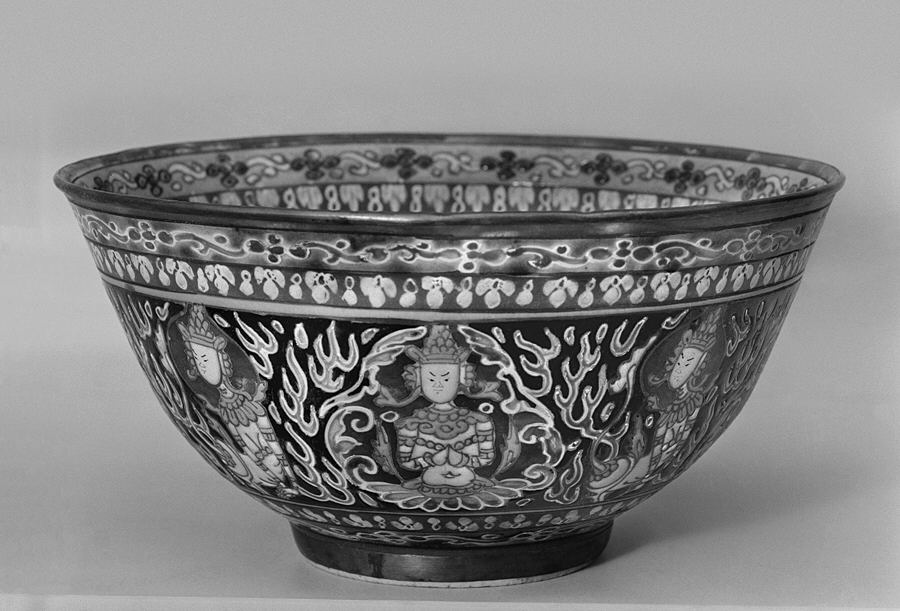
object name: bowl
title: Bowl with mythical Thai figures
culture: chinese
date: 1801-1900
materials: enamel, porcelain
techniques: overglaze, painting, polychrome